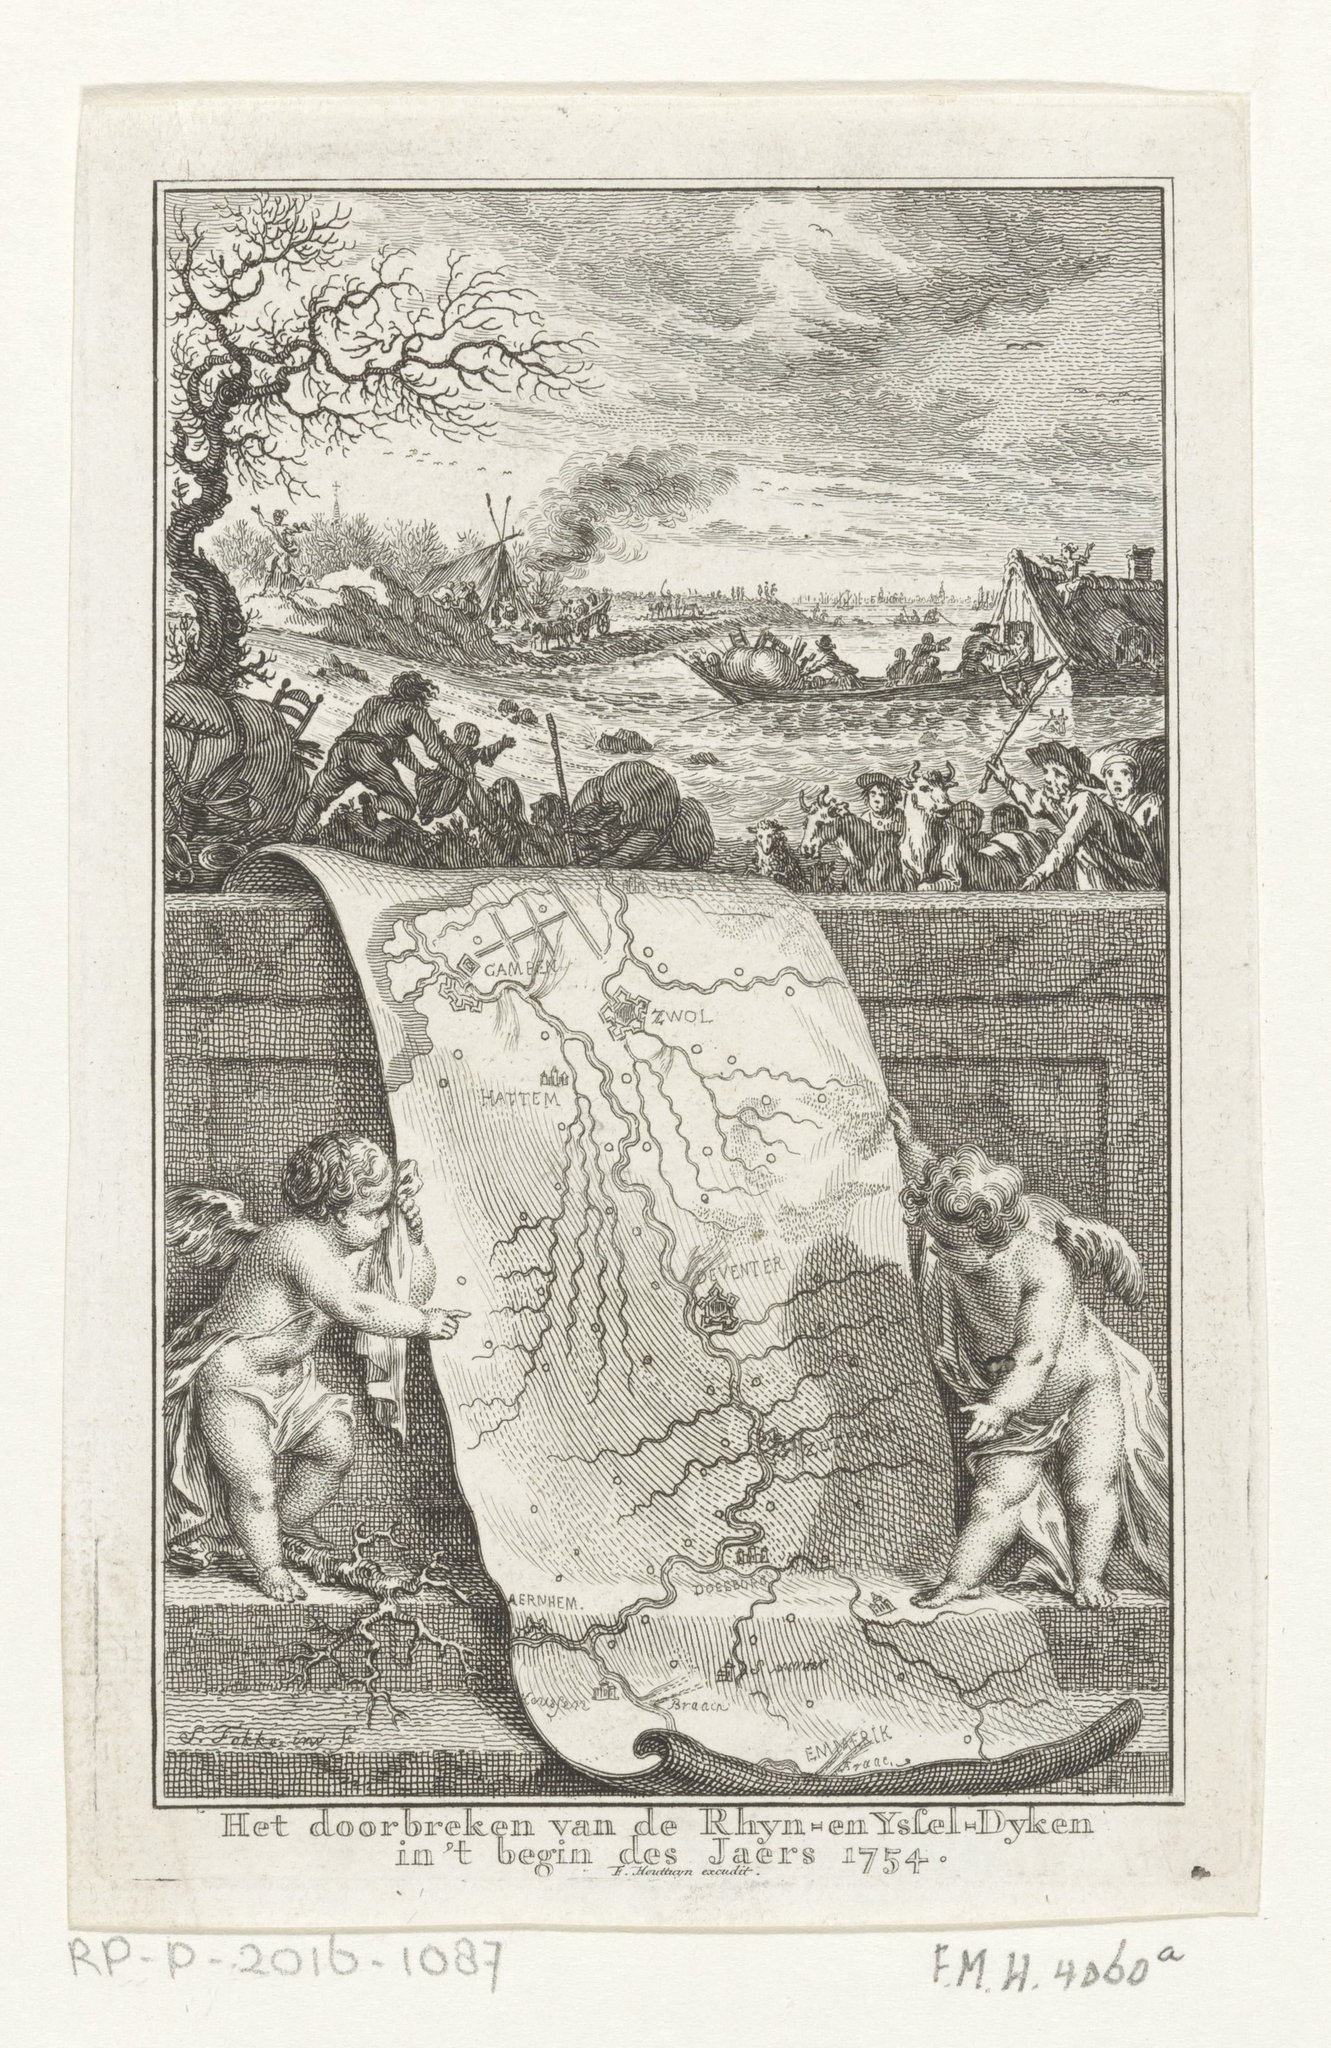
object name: print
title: Het doorbreken van de Rhyn- en Yssel-Dyken in't begin des Jaers 1754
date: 1754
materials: paper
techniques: engraving, etching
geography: amsterdam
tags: dike-break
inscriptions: collector's mark: Lugt 2228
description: Prent uit: S.n. Nederlandsche jaerboeken, inhoudende een Verhaal van de merkwaerdigste geschiedenissen, die voorgevallen zyn binnen den omtrek der Vereenigde Provintien, sederd het begin des jaers MDCCXLVII, achtste deel. Amsterdam: Houttuyn, Frans, 1754. Prent afkomstig uit een plakalbum met titelprenten, ornamenten etc. op blauw papier in 1983 uit elkaar gehaald. Volgens een notitie op verso zat de prent op p. 103 van dit album.